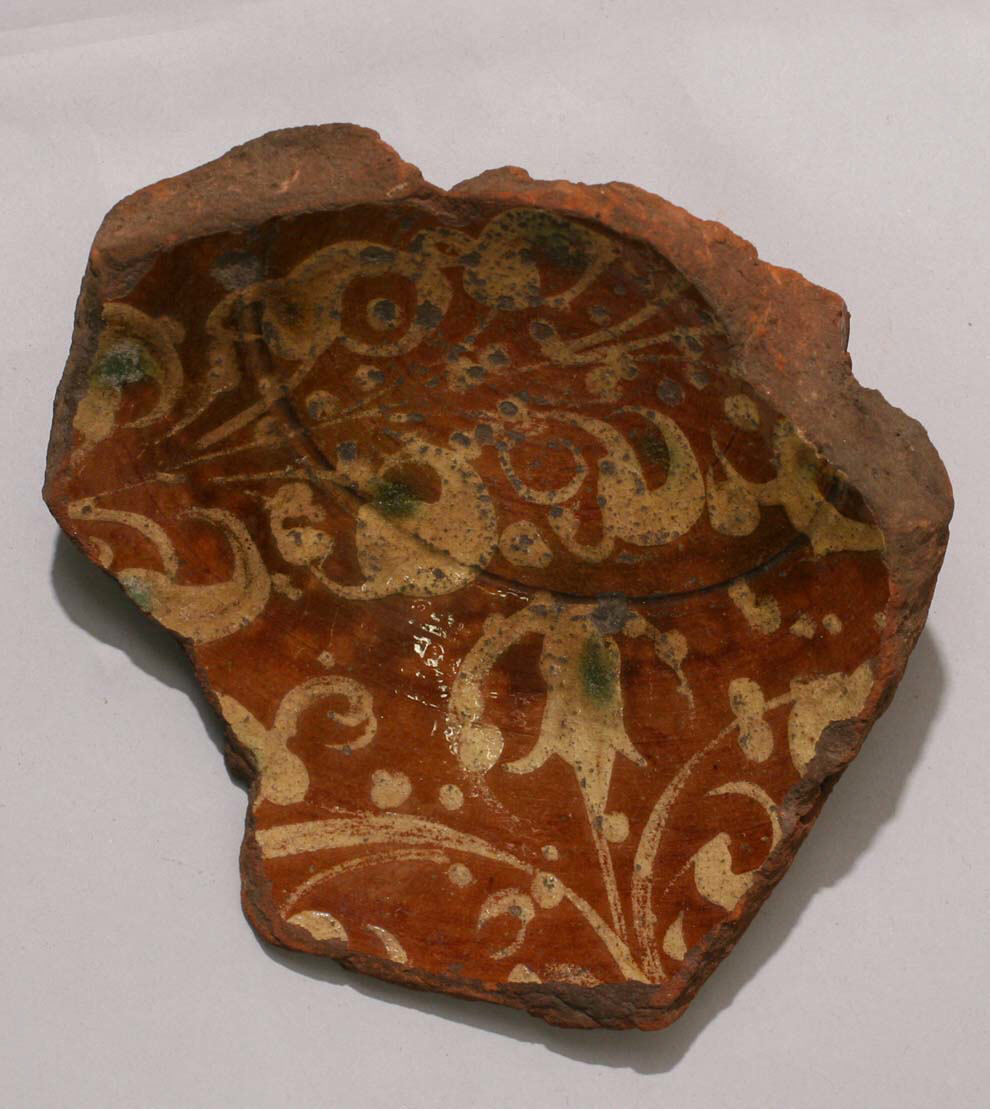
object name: ceramic fragment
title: Fragment of a Bowl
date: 1301-1500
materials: earthenware, glaze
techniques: painting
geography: egypt